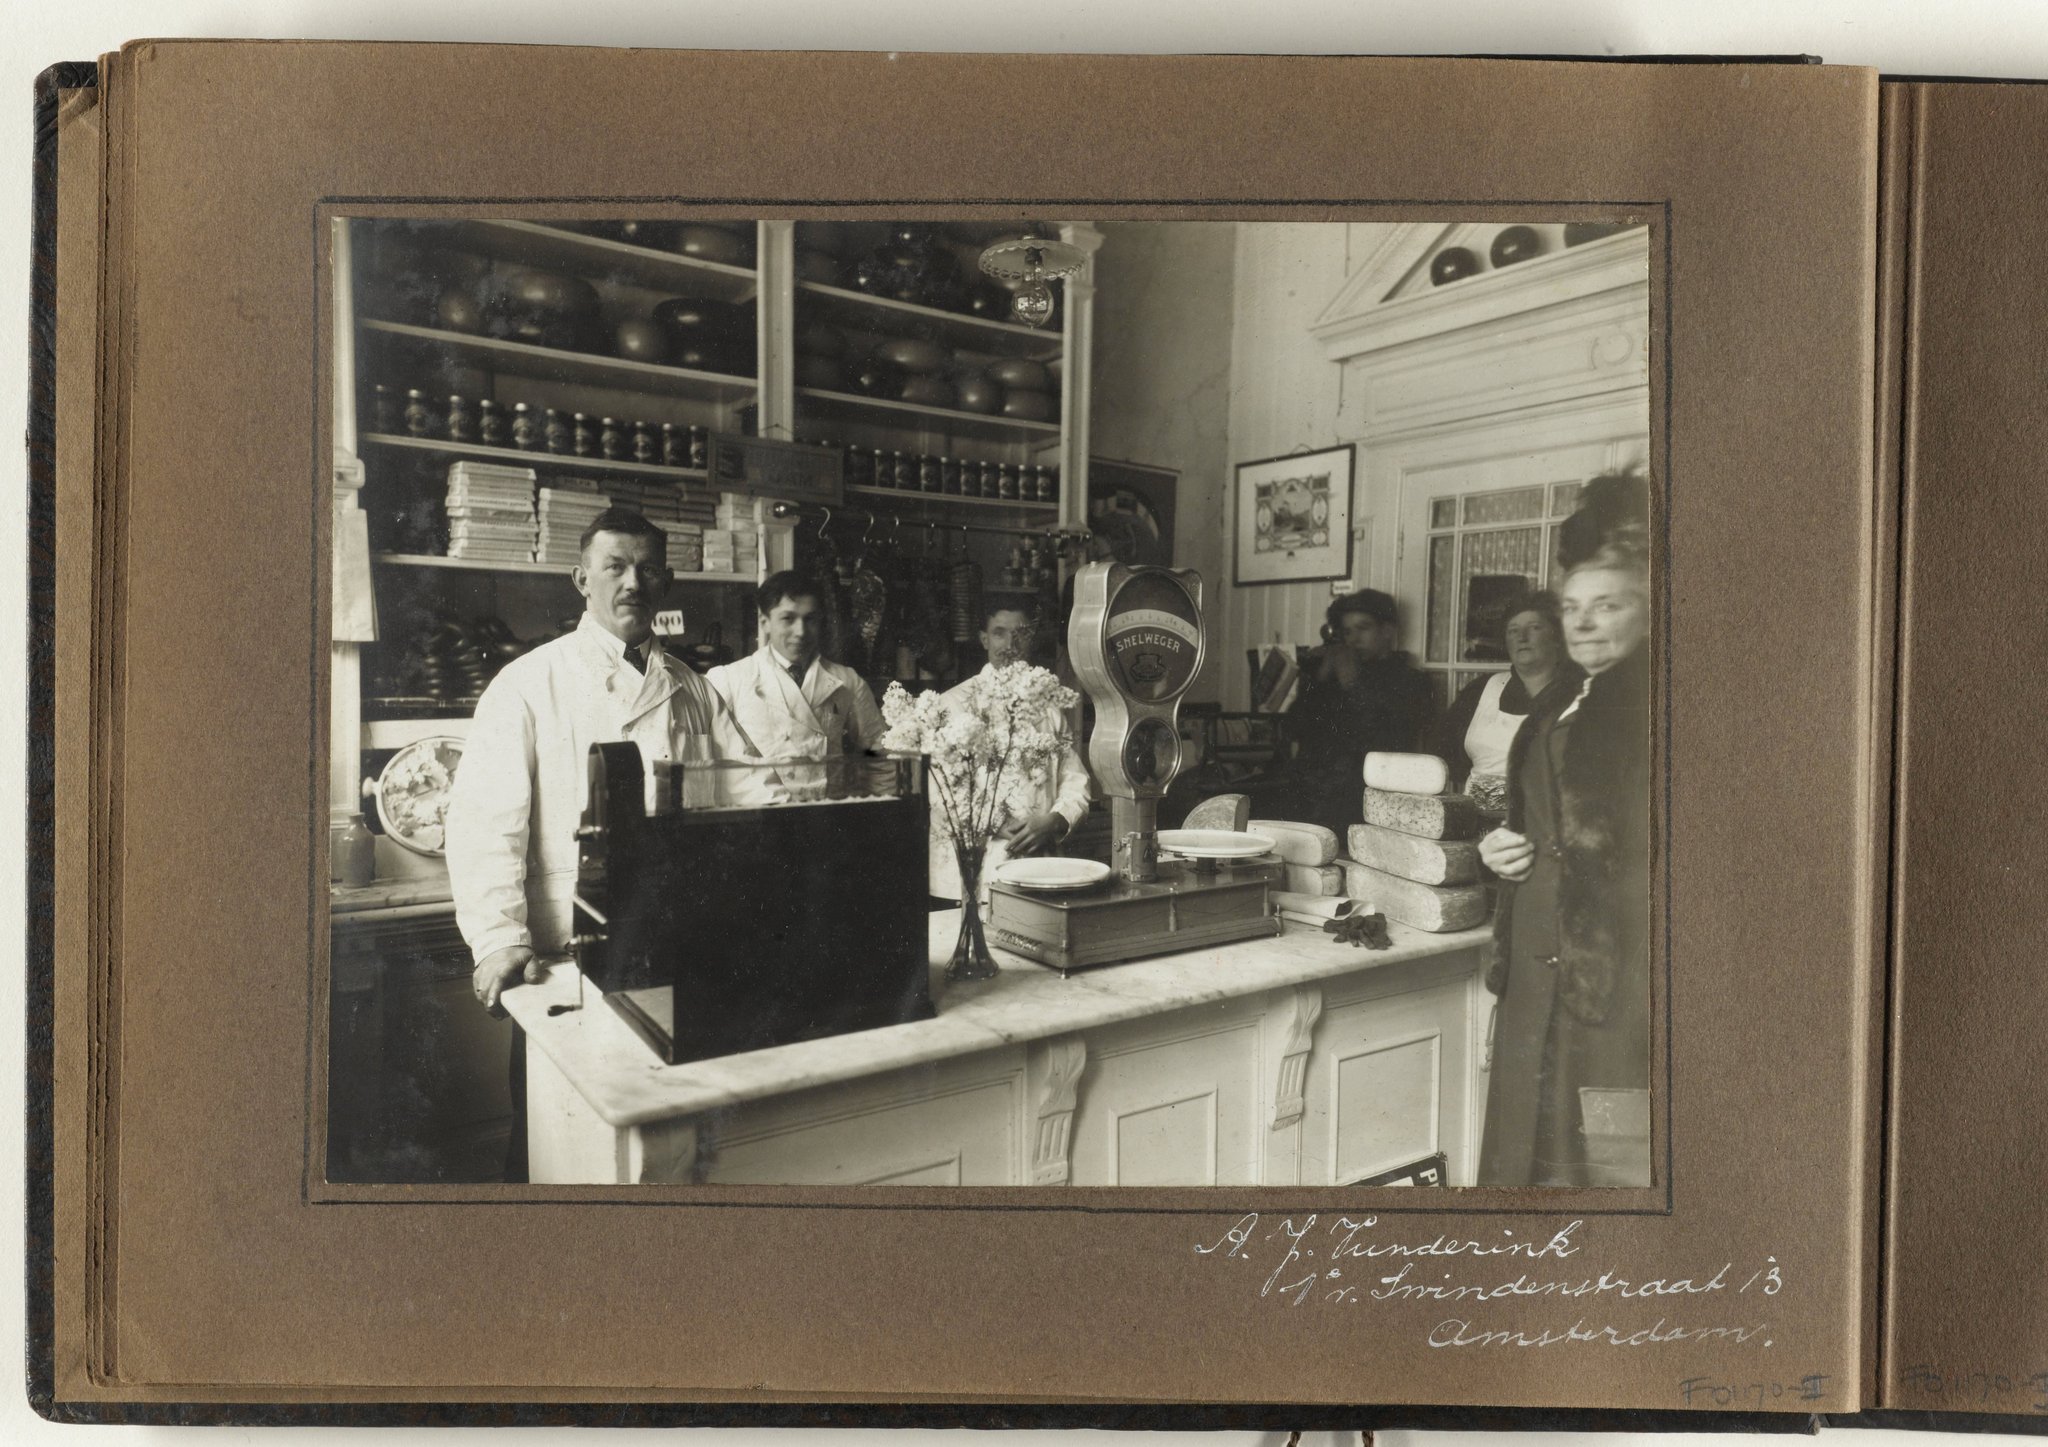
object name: photograph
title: Interieur van de kaaswinkel van A.J. Vunderink, Eerste Van Swindenstraat 13, Amsterdam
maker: Anonymous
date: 1925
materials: paper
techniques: gelatin silver print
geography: amsterdam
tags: counter ~ shop, cheese, amsterdam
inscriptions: annotation: ‘A.J. Vunderink/ 1e v. Swindenstraat 13/ Amsterdam’